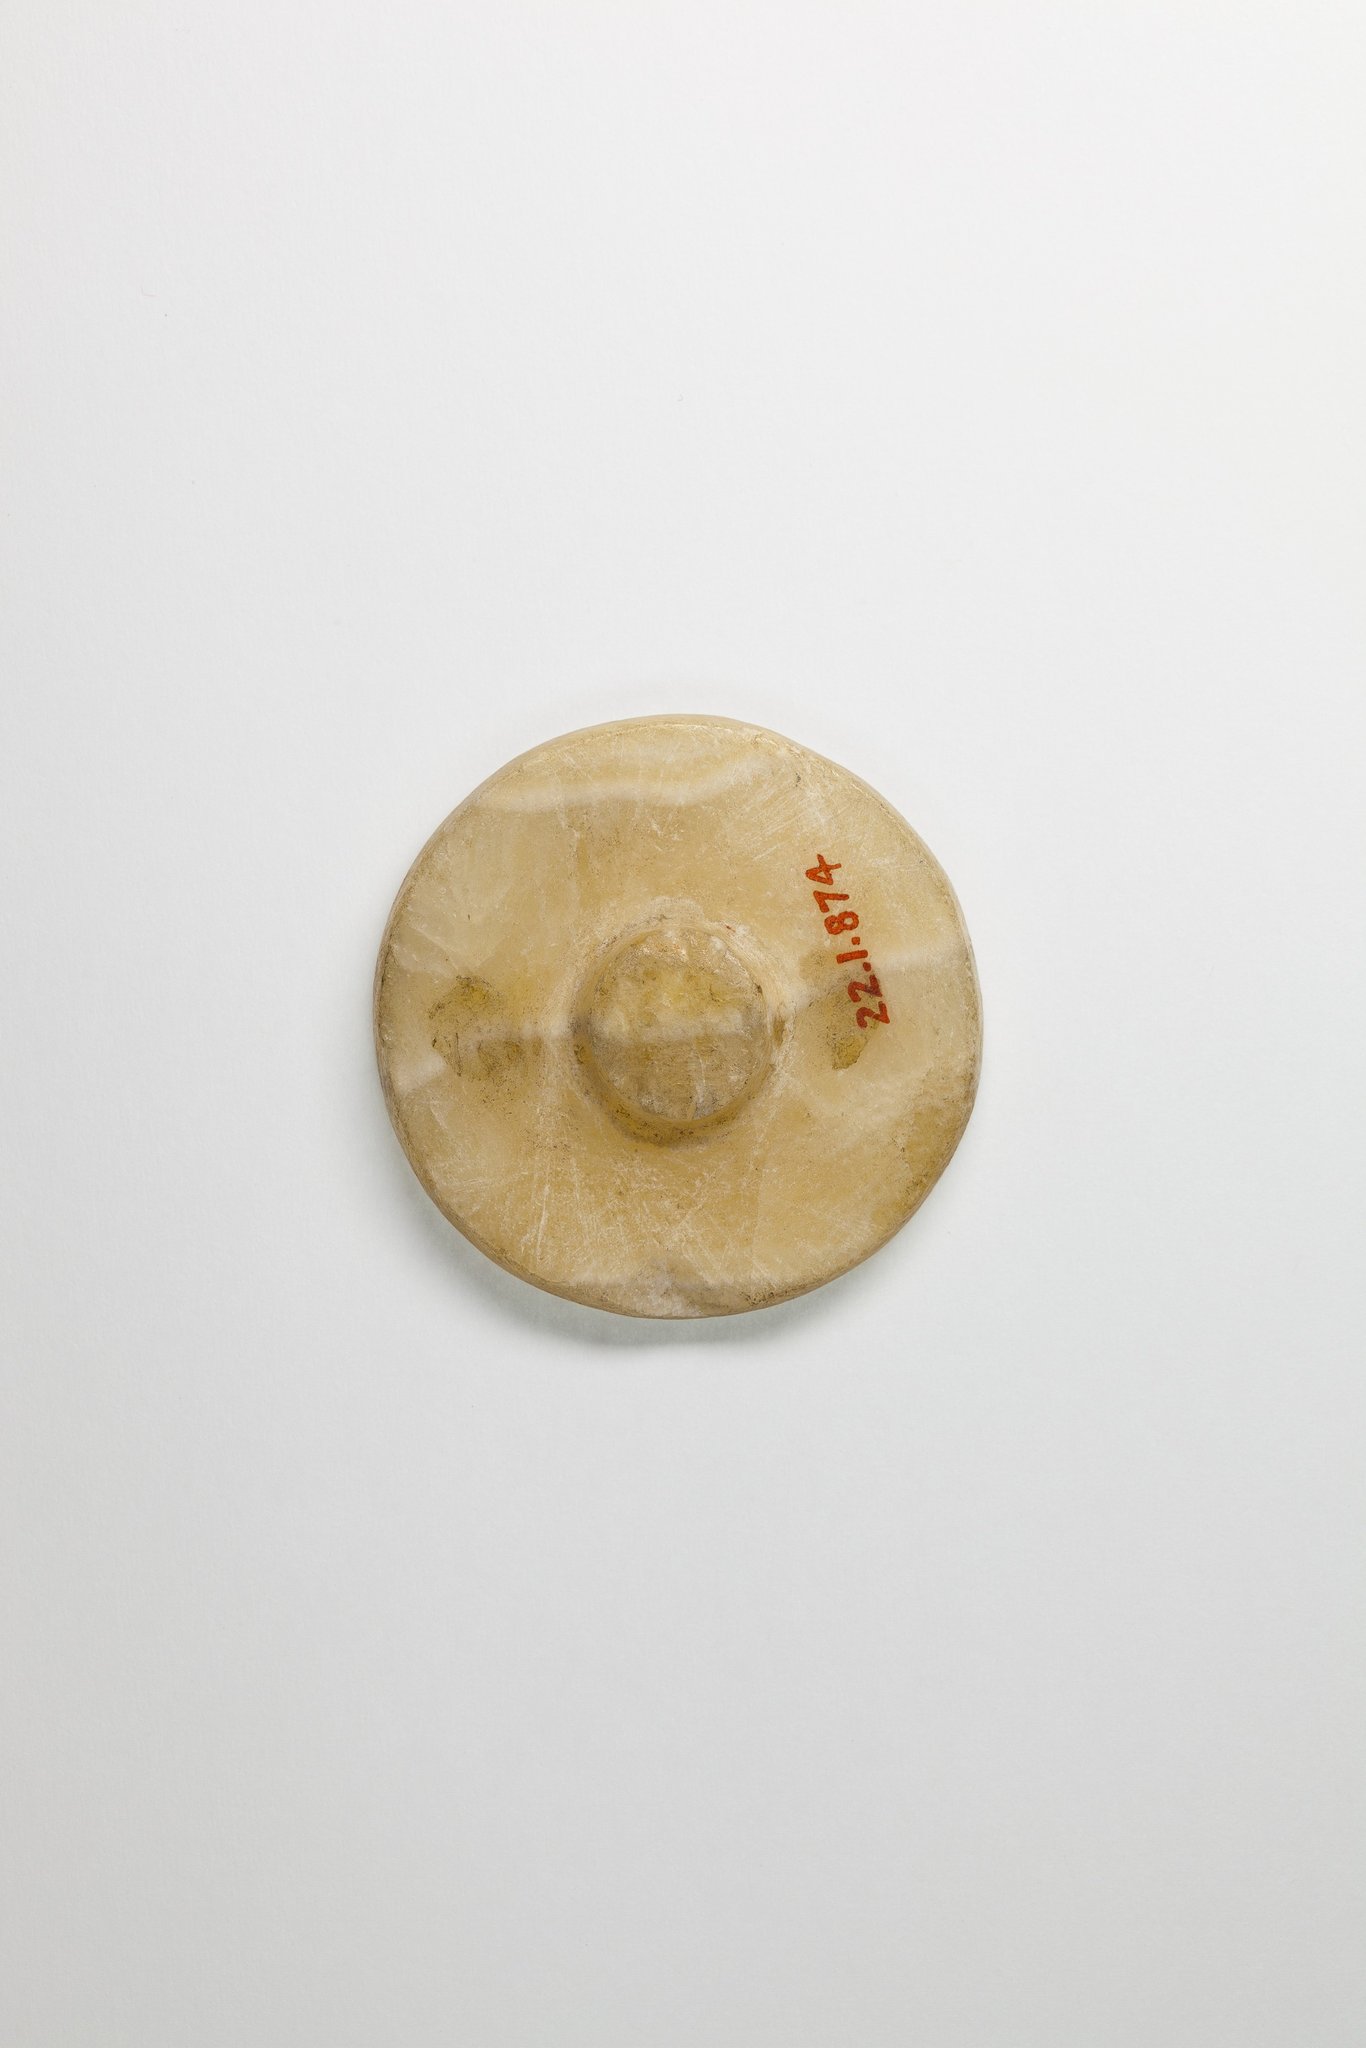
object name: kohl jar lid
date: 1981-1640 BCE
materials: stone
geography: egypt